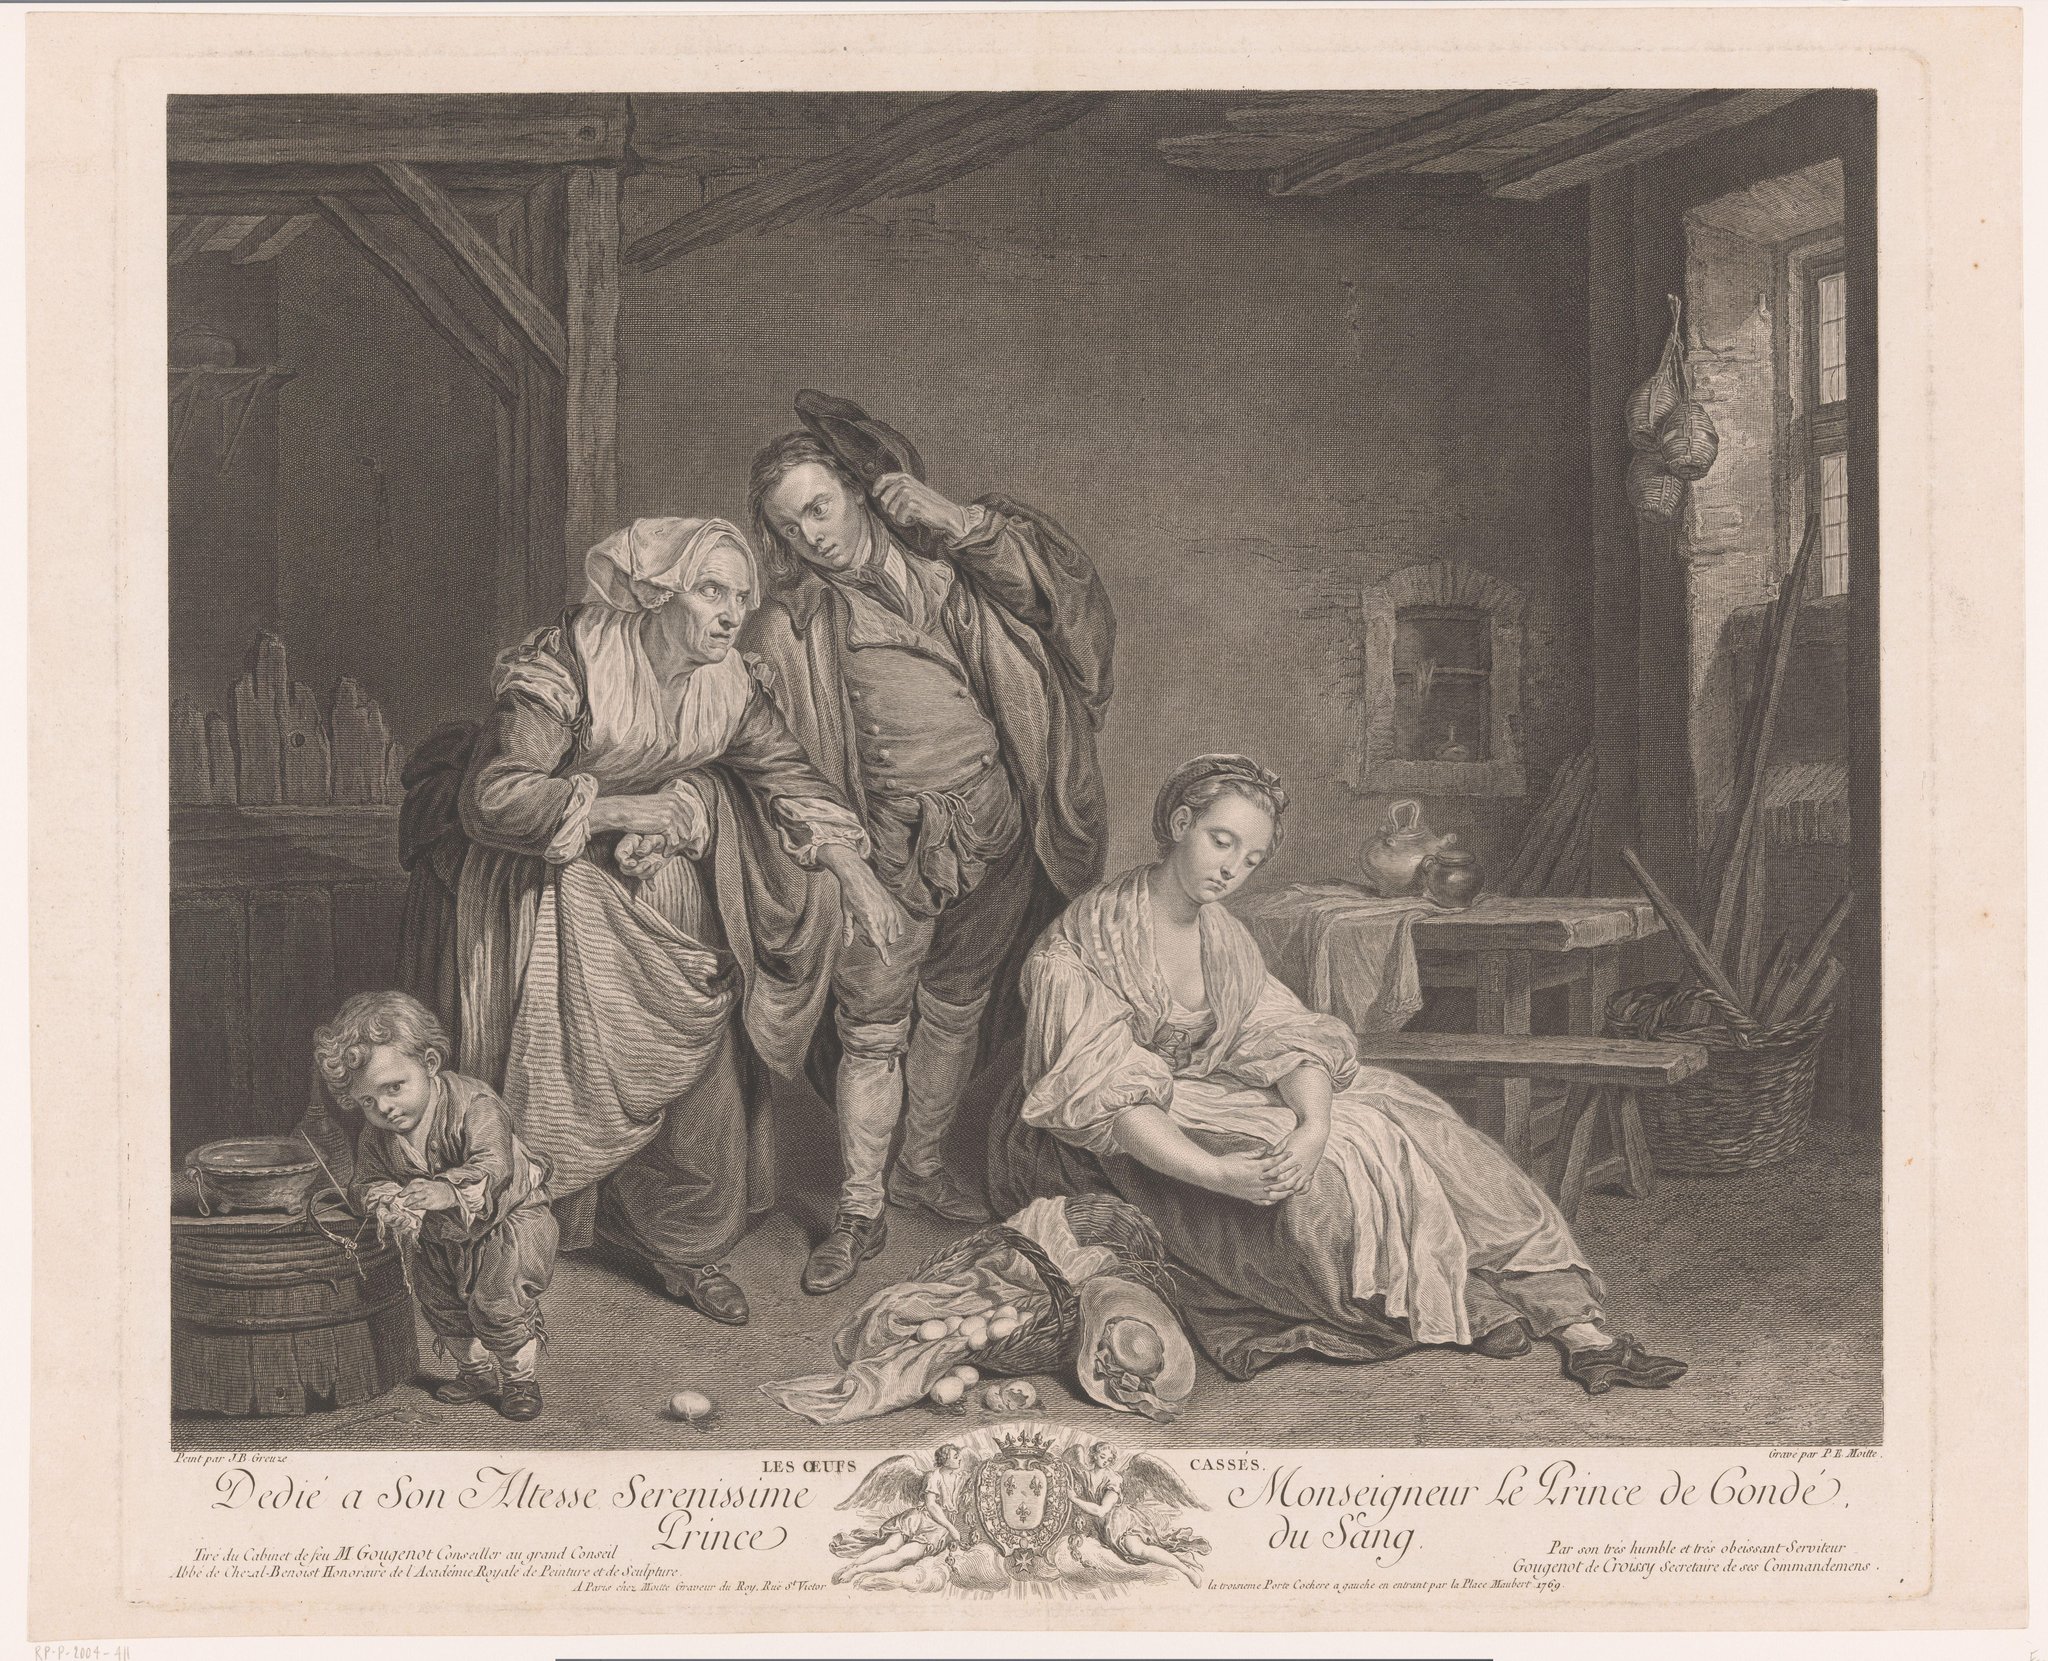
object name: print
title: Jonge vrouw naast een mand met gebroken eieren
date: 1769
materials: paper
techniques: engraving, etching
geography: paris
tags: animals (+ egg), loss of virginity symbolized, lovers; courting, flirting, parents (first degree family relationships)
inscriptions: collector's mark: Lugt 2760, collector's mark: Lugt 2228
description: Allegorie op het verlies van maagdelijkheid. Jonge vrouw met naast haar een mand met gebroken eieren. Een oude vrouw wijst ernaar en heeft met één hand een jongeman vast. Links een klein kind.